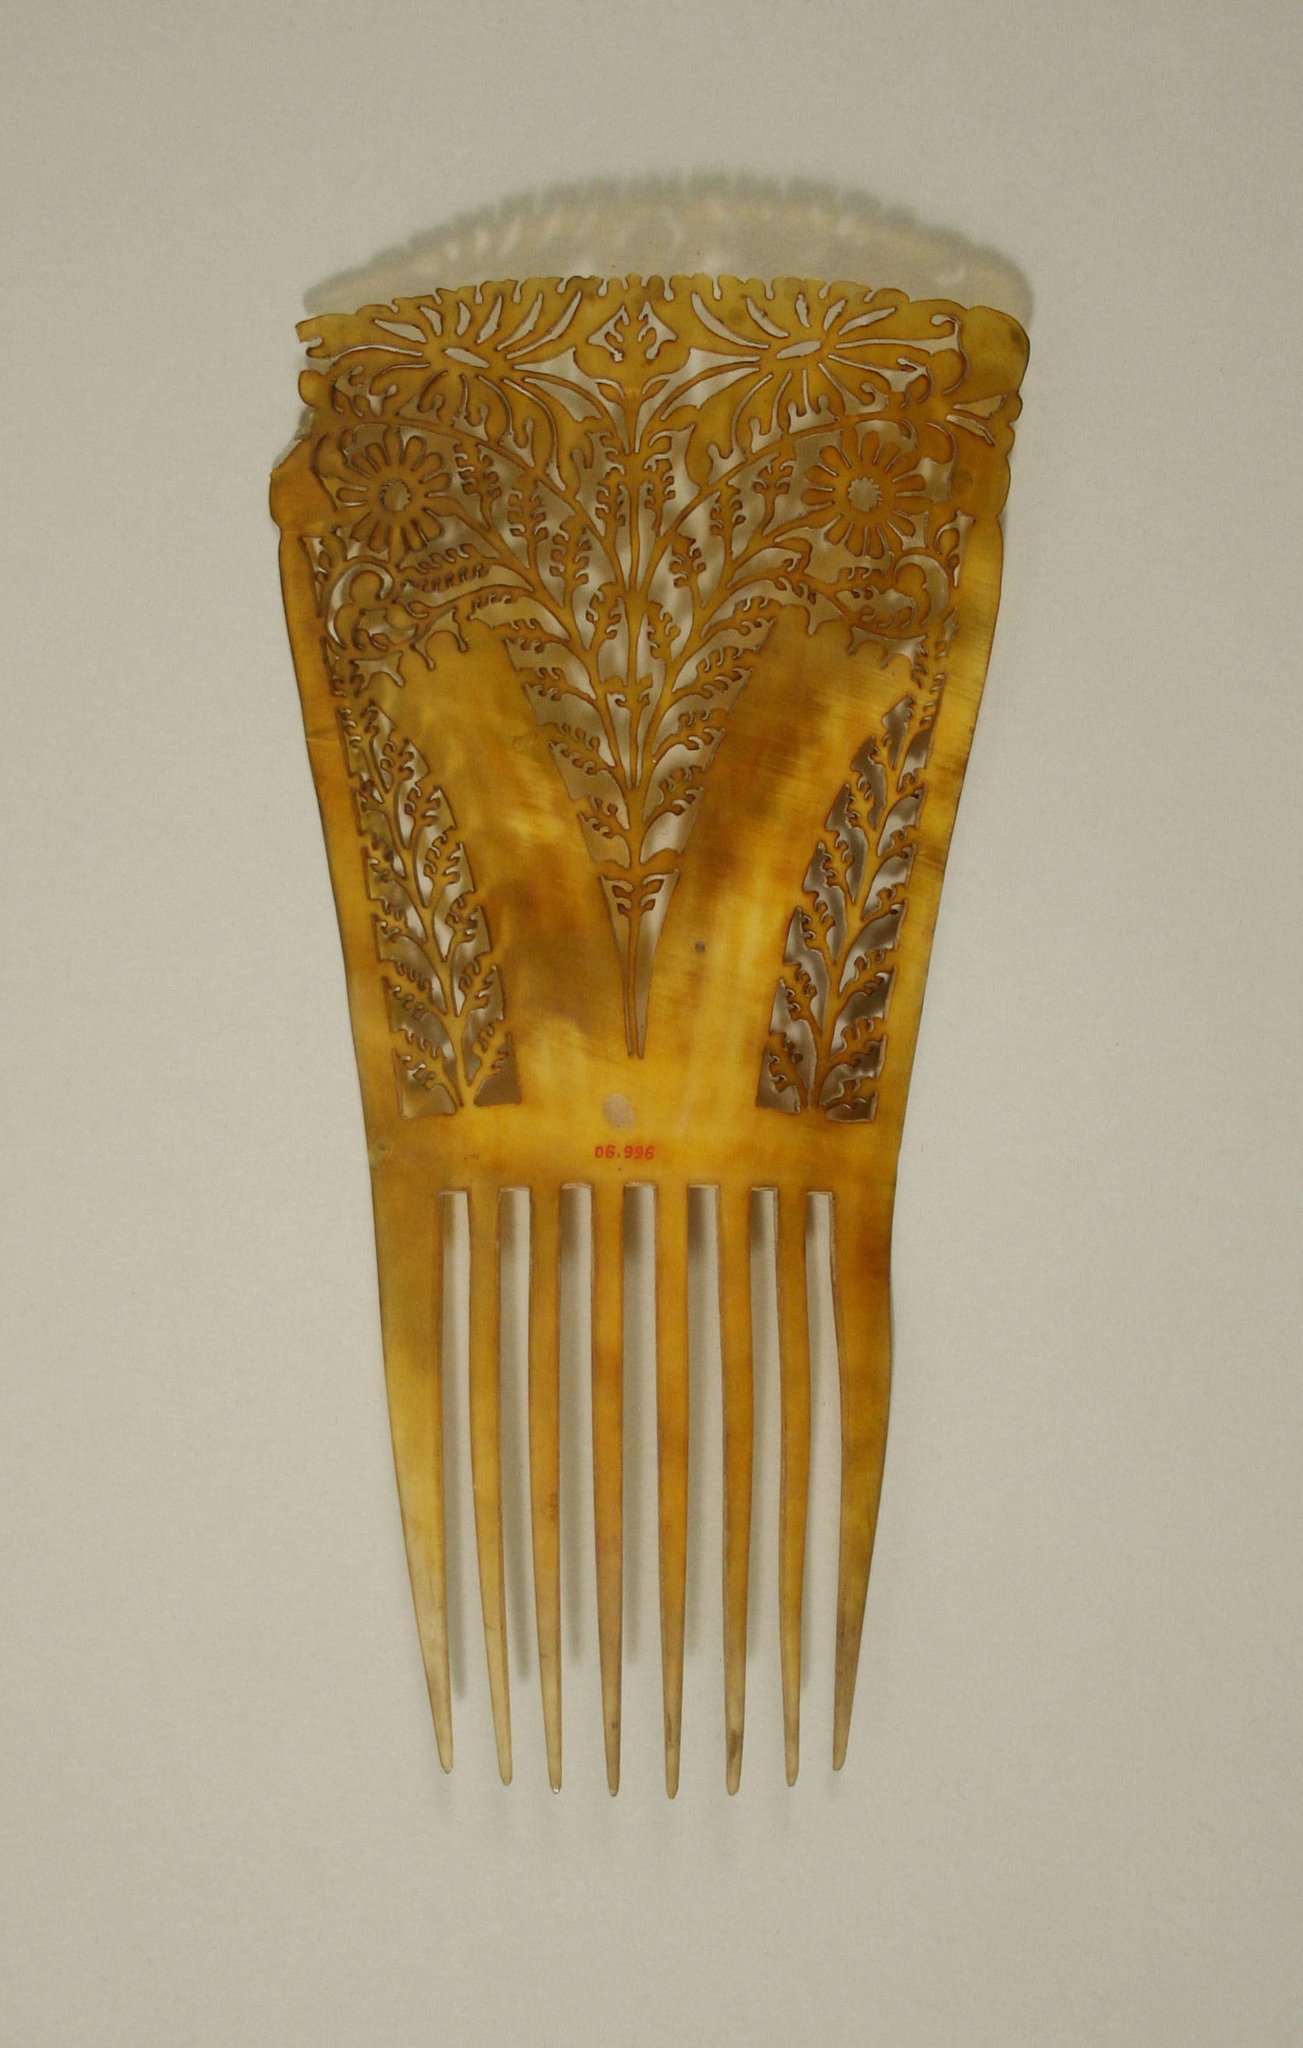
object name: comb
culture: german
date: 1801-1900